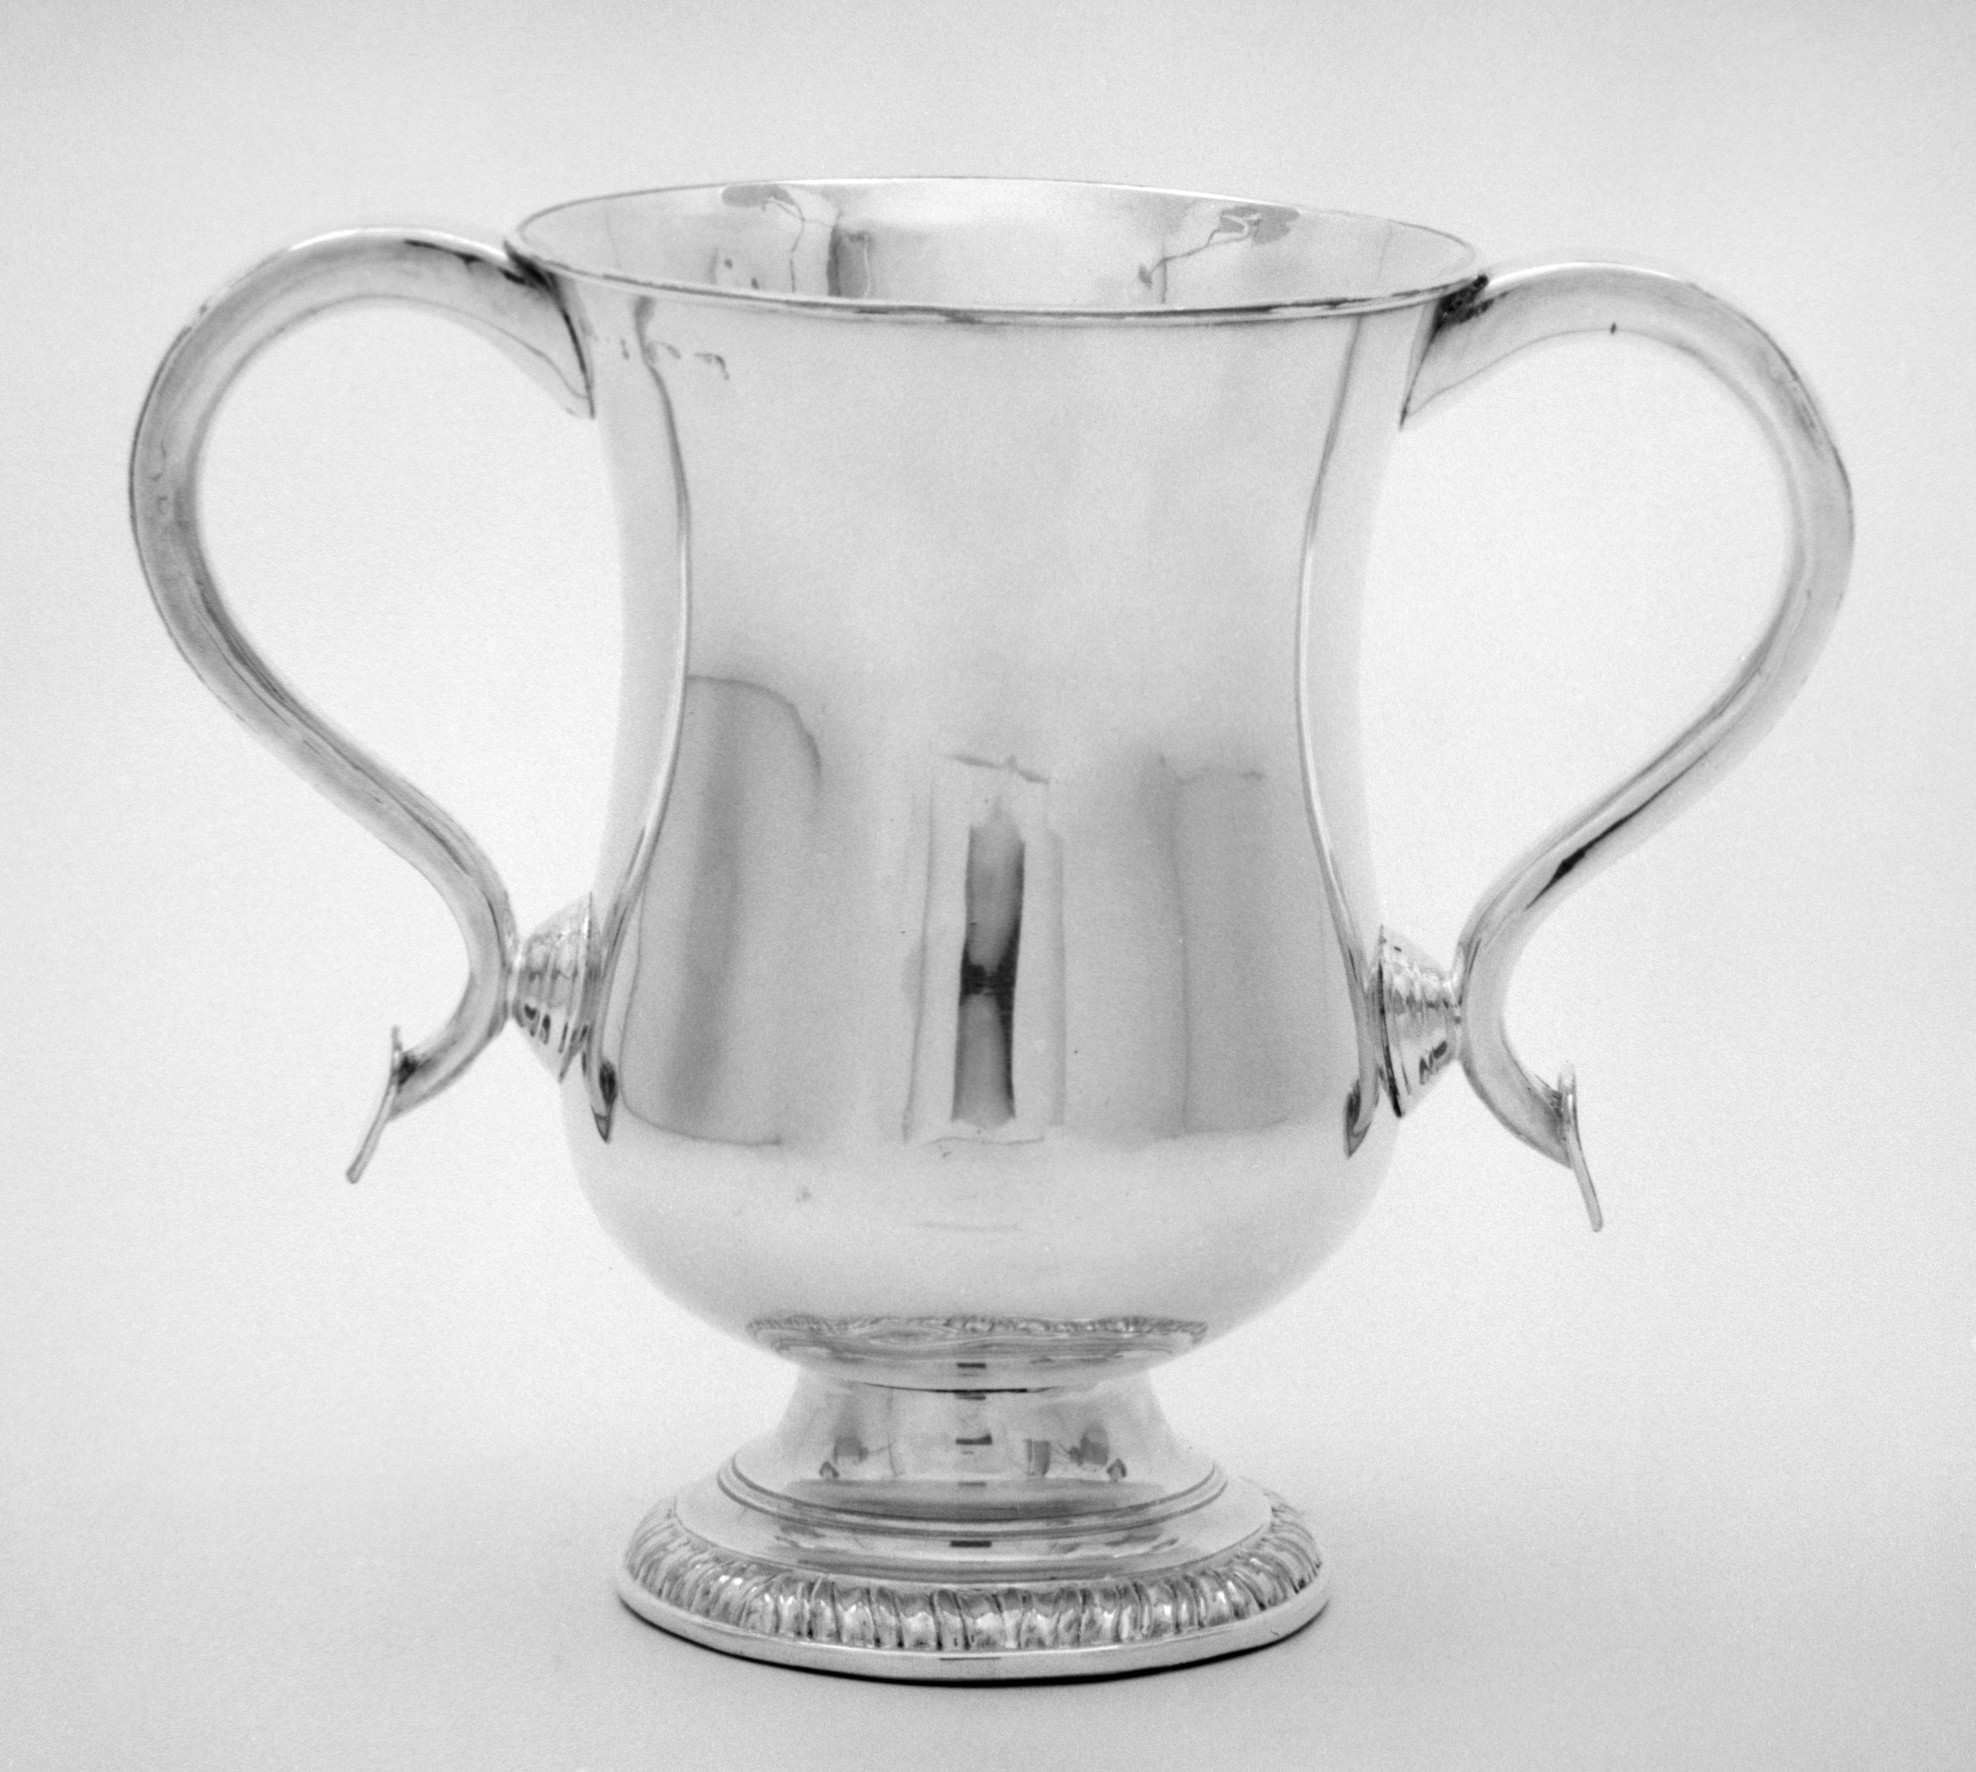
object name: cup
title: Two-handled cup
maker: john hoyland and co.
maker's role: maker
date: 1764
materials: metal, wood